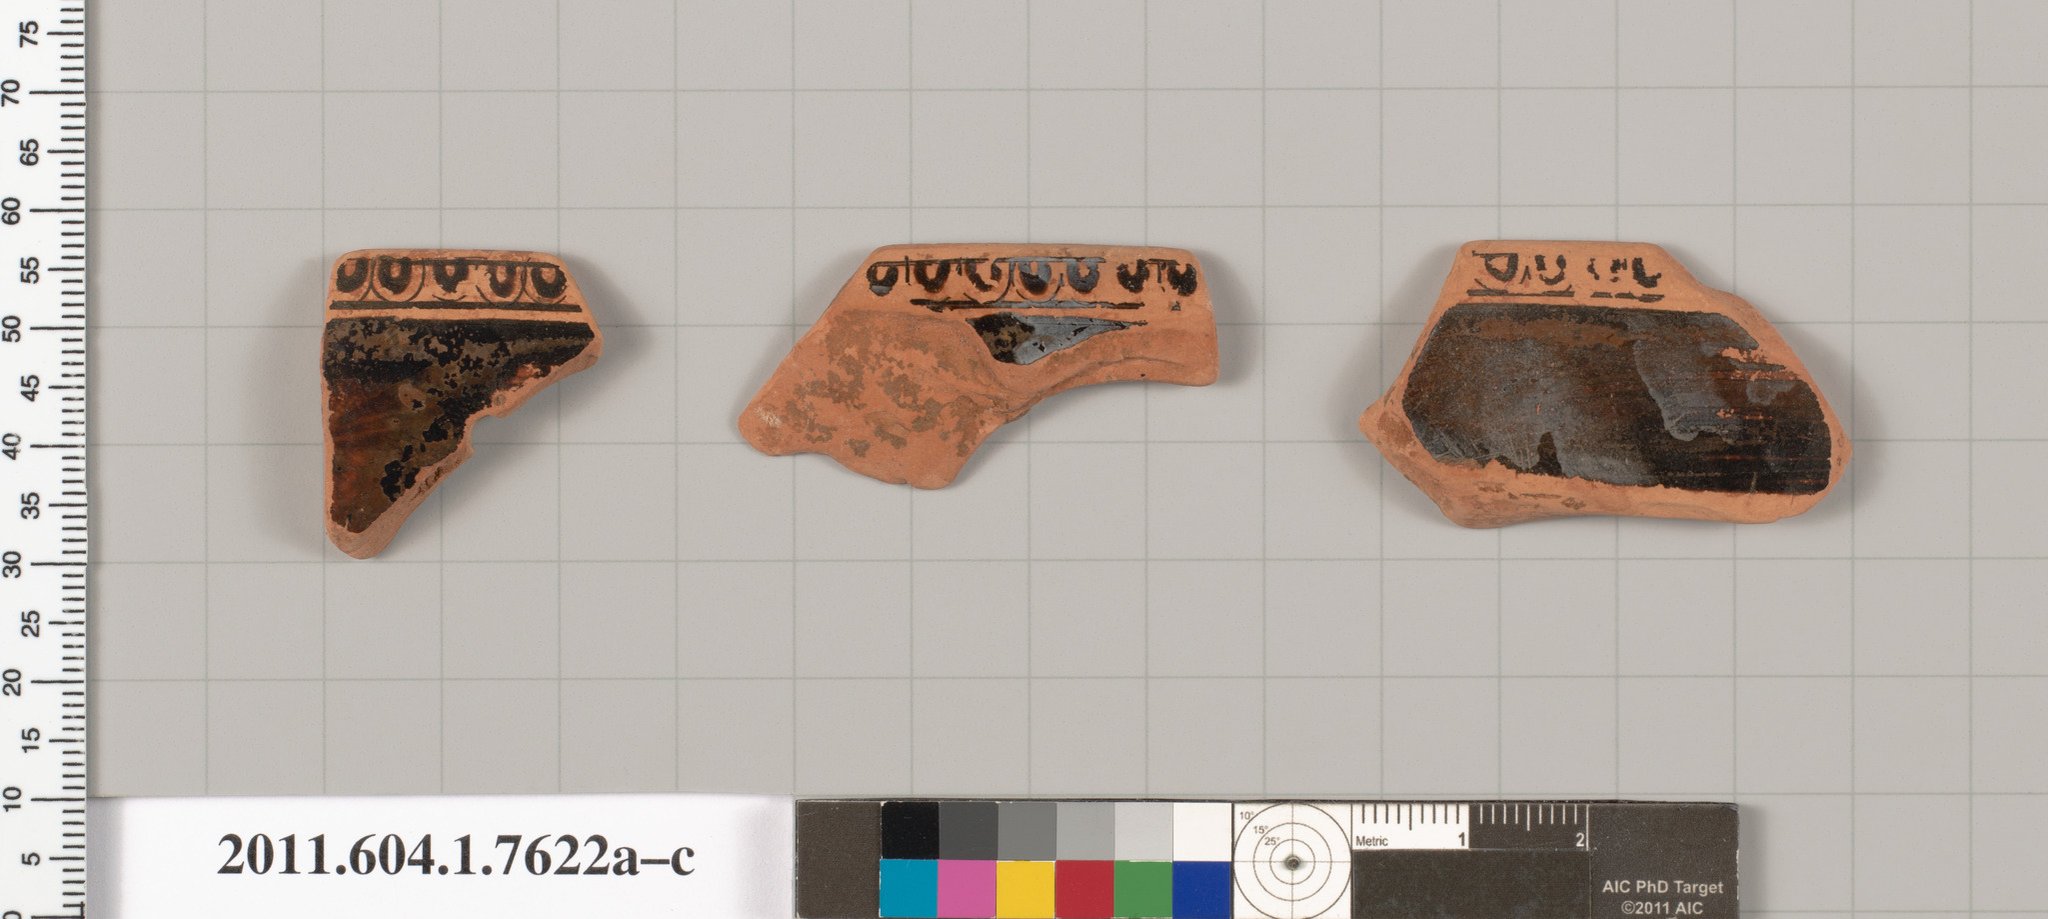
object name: kylix fragment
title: Terracotta rim fragments of kylikes (drinking cups)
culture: greek, attic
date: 460-450 BCE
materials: terracotta